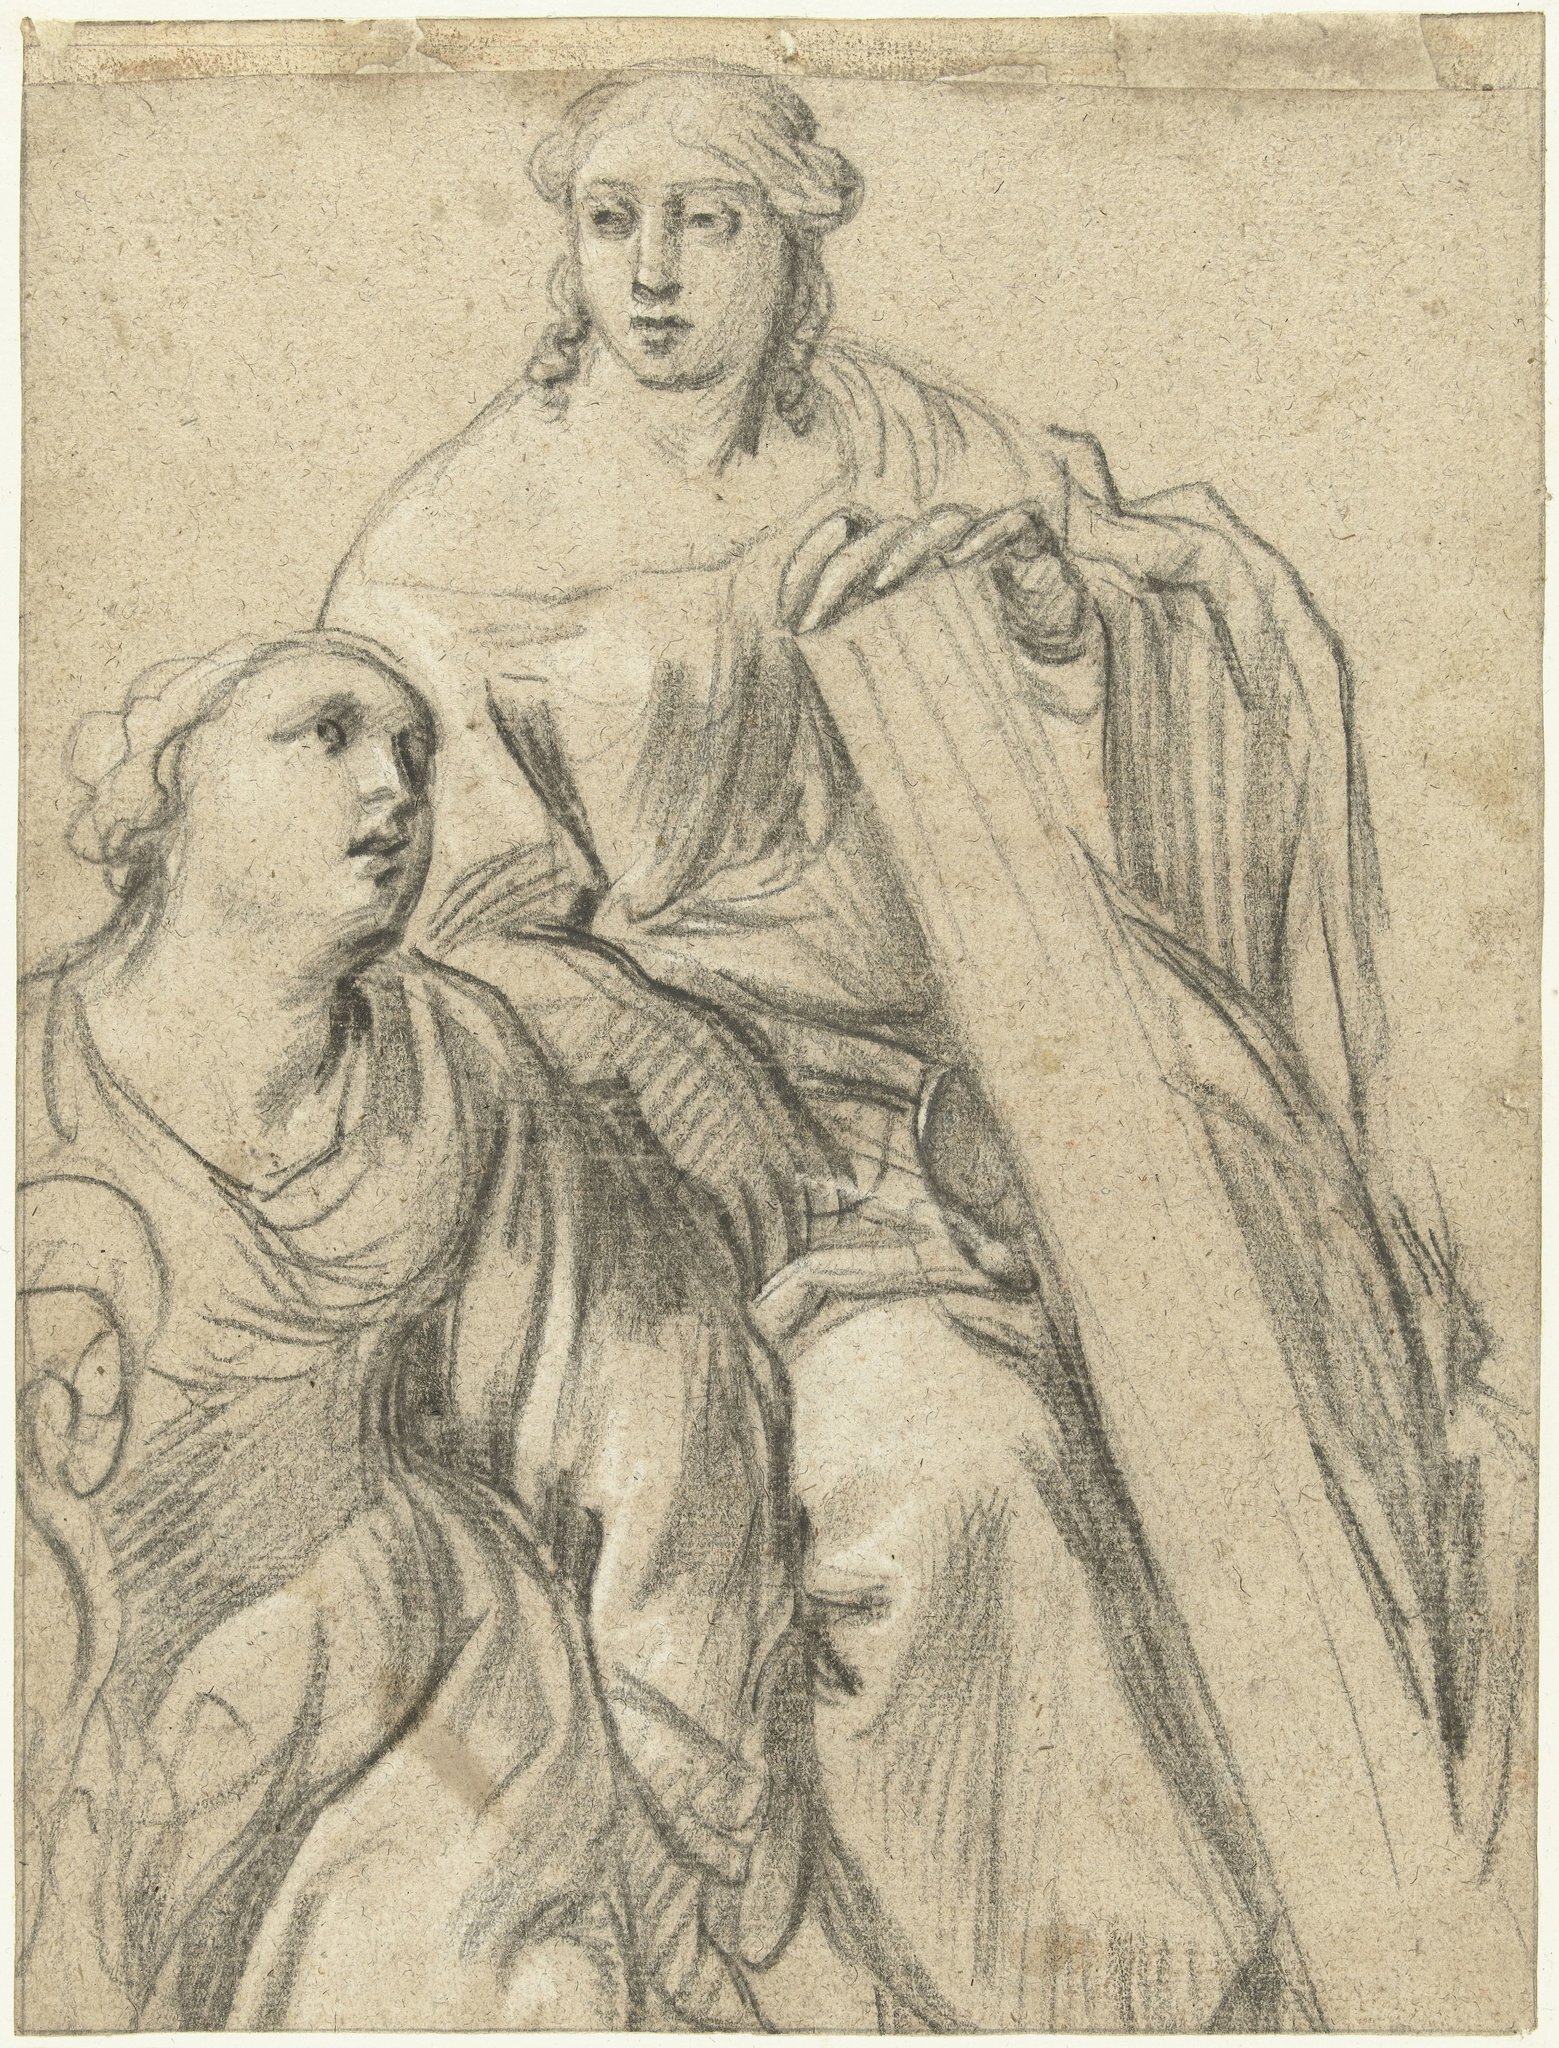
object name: drawing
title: Twee vrouwenfiguren, zittend naar rechts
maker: simon vouet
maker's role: draughtsman, print maker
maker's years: 1590-1649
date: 1600-1659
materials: chalk, paper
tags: sitting figure - aa - female human figure